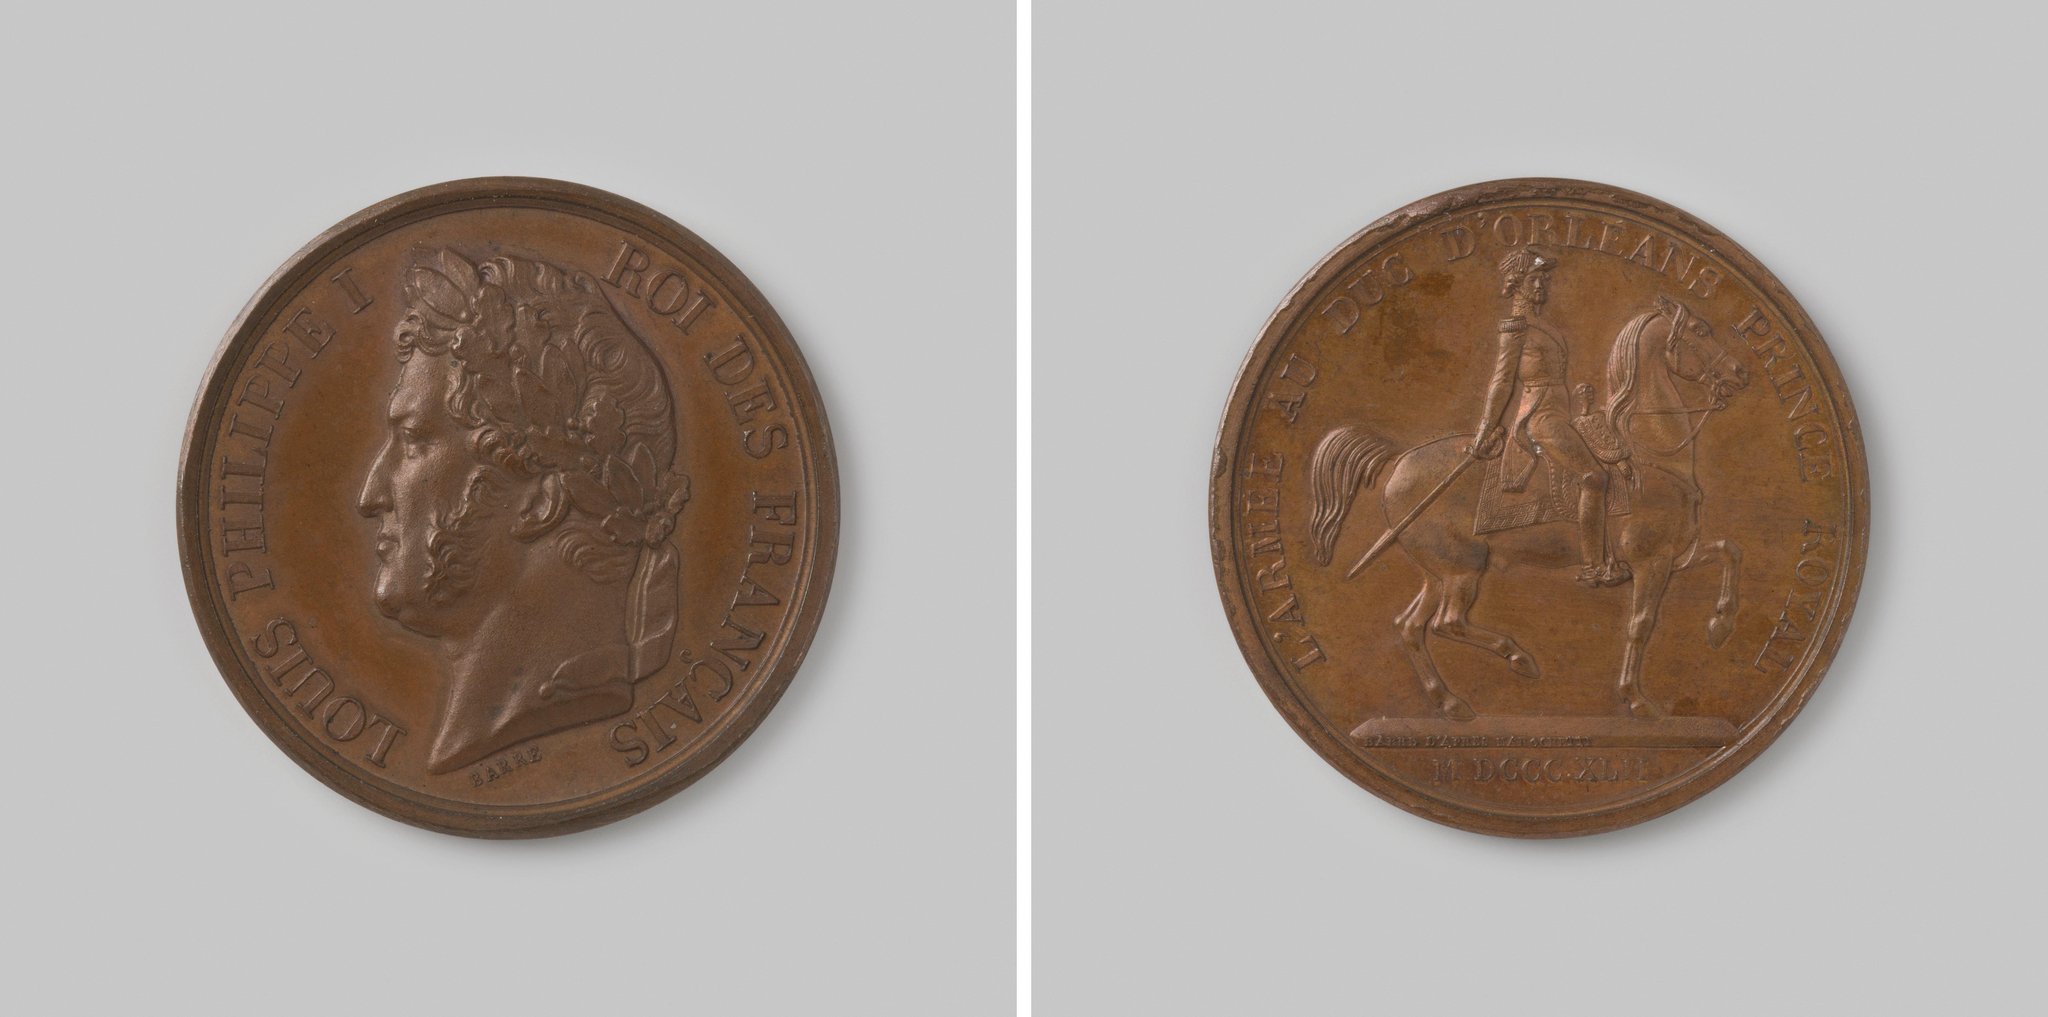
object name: history medal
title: Overlijden van de Hertog van Orleans 1842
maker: désiré-albert barre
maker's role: graficus, medailleur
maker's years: 1818-1878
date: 1842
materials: copper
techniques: striking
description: Bronzen penning, op de voorzijde het portret van Koning Louis-Philippe naar links met omschrift, op de keerzijde de Hertog van Orleans te paard naar rechts met omschrift en afsnedetekst.